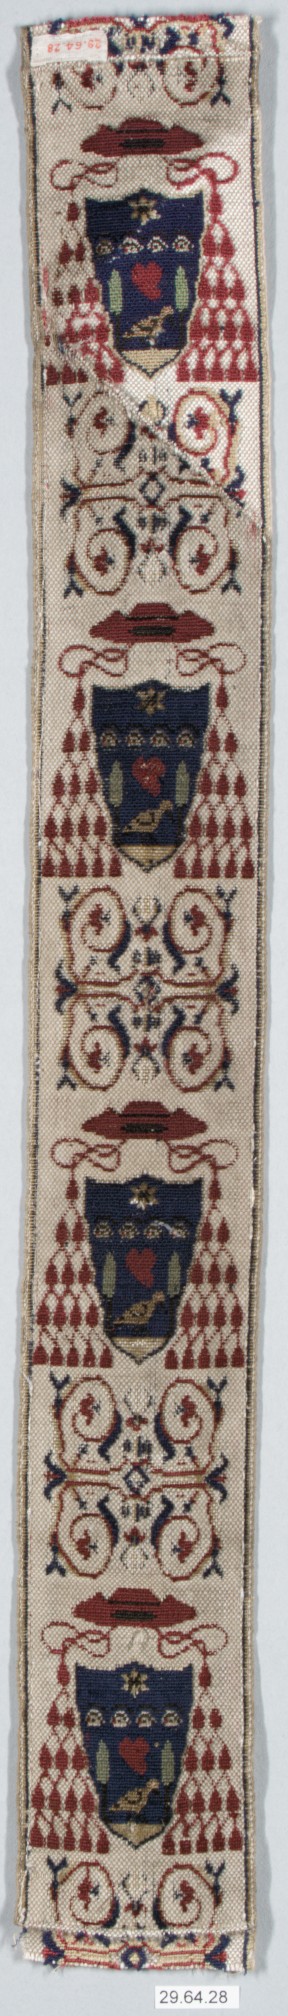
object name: galloon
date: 1701-1900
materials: silk